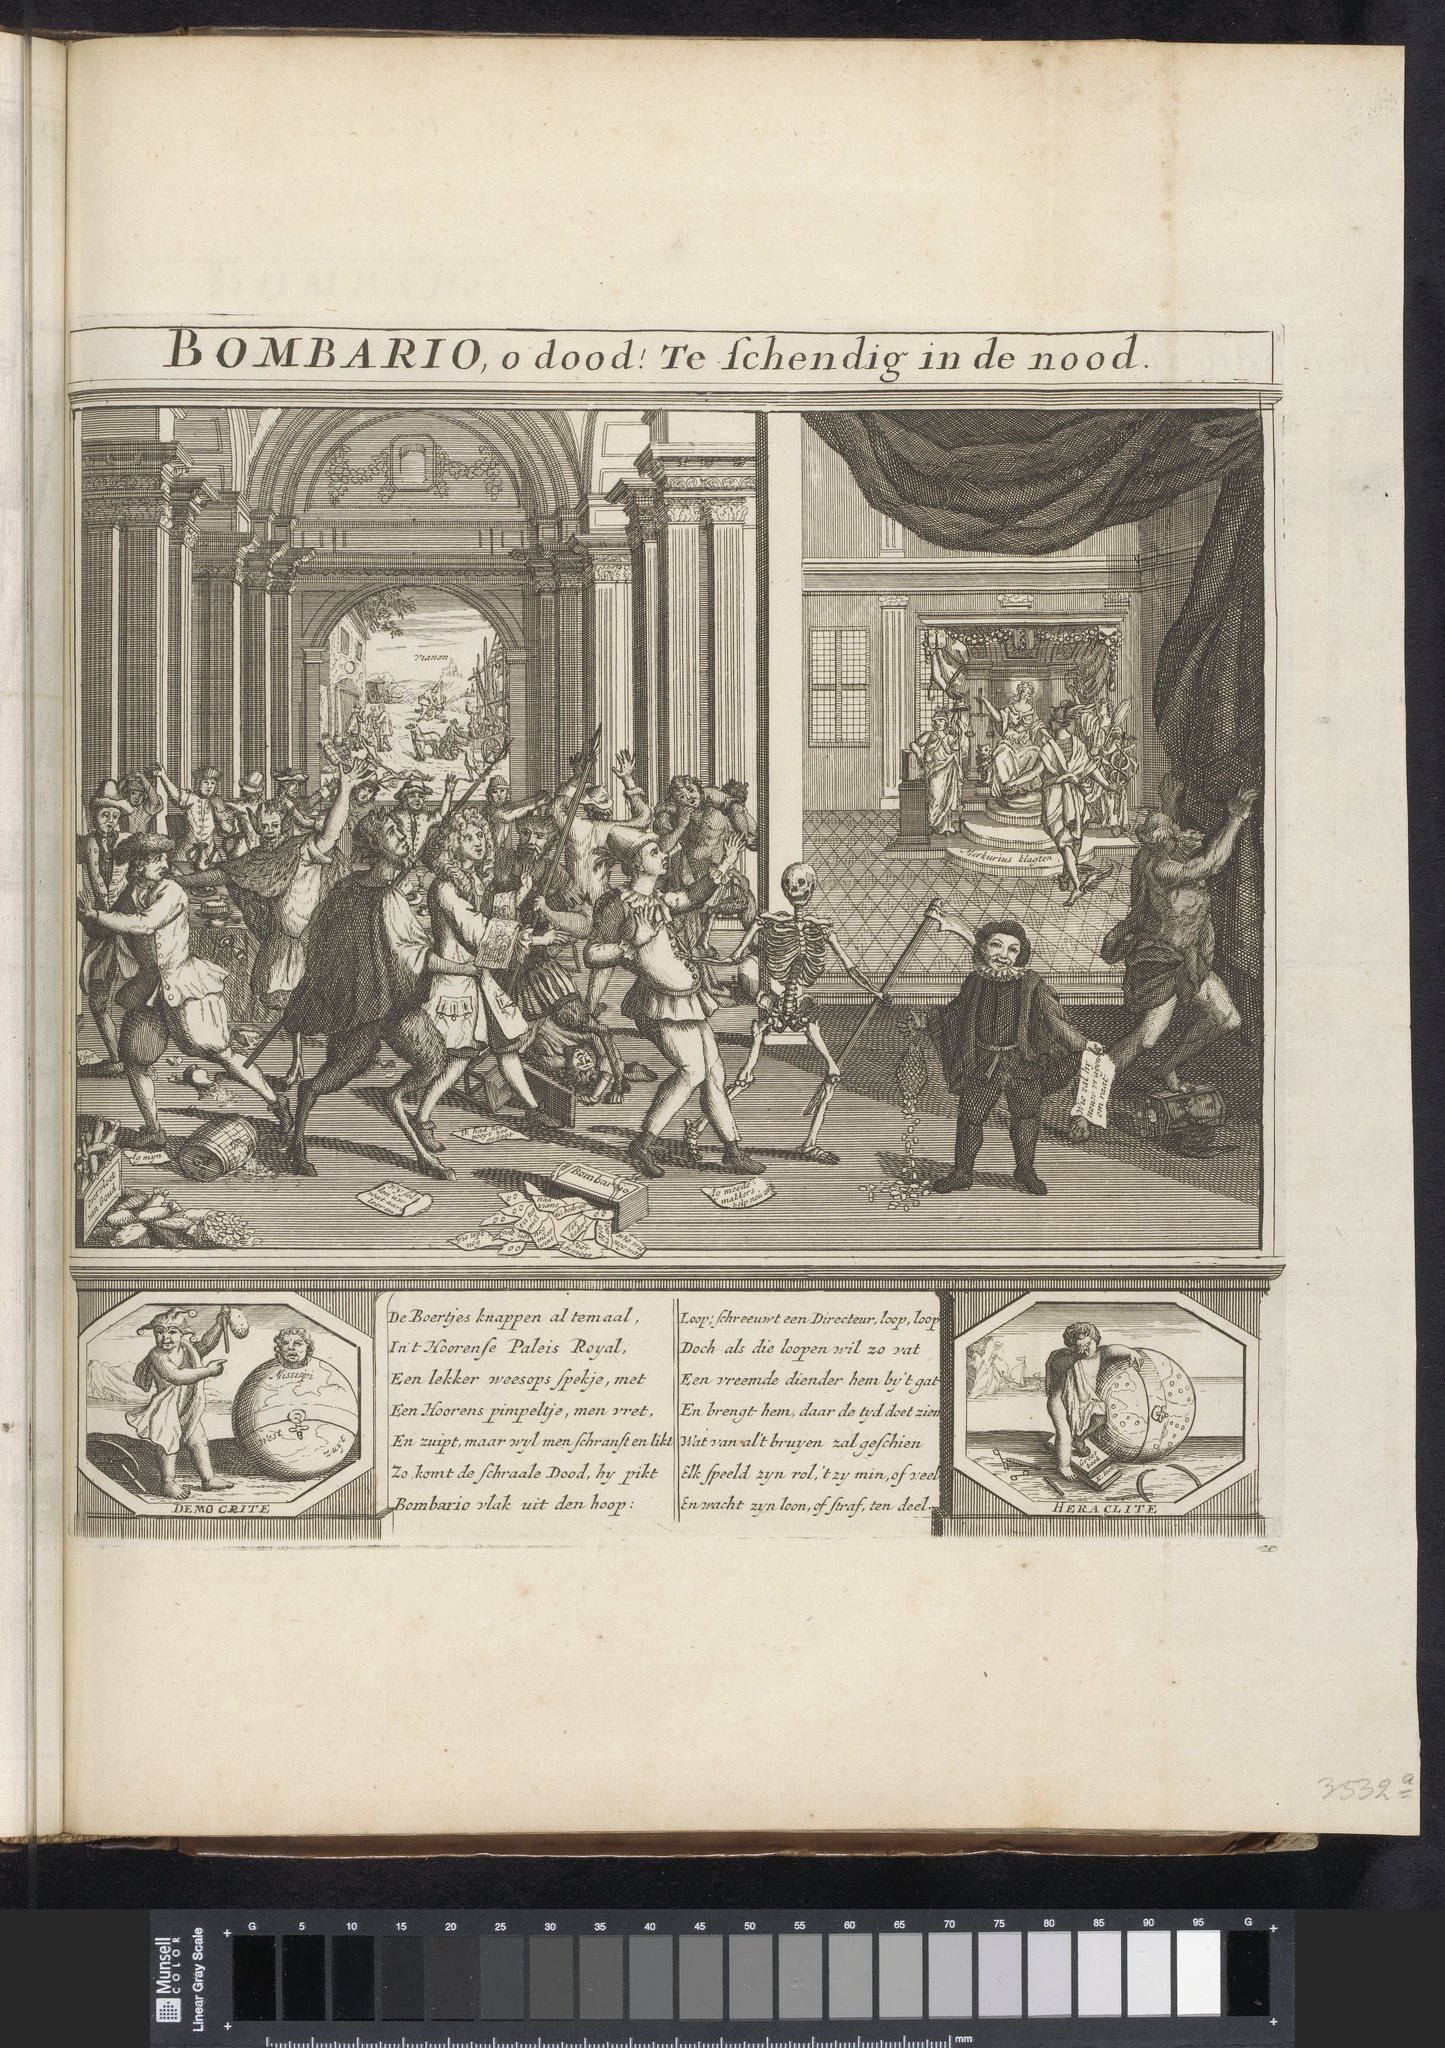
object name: cartoon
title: Bombario, o dood! Te schendig in de nood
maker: Anonymous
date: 1720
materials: paper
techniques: etching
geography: northern netherlands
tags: financial panic, death as skeleton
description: In een paleis wordt de harlekijn Bombario door de Dood weggeleid, andere handelaren worden door duivels meegenomen. Rechts doet Mercurius zijn beklag voor de troon van Rechtvaardigheid. Onderaan Democritus en Heraclitus. Democritus lachende bij een wereldbol waarop de Mississippi-Compagnie. In het onderschrift een vers in twee kolommen. Prent in de gebonden eerste uitgave (304 B 11) van Het Groote Tafereel der Dwaasheid met spotprenten op de Windhandel of Actiehandel van 1720.